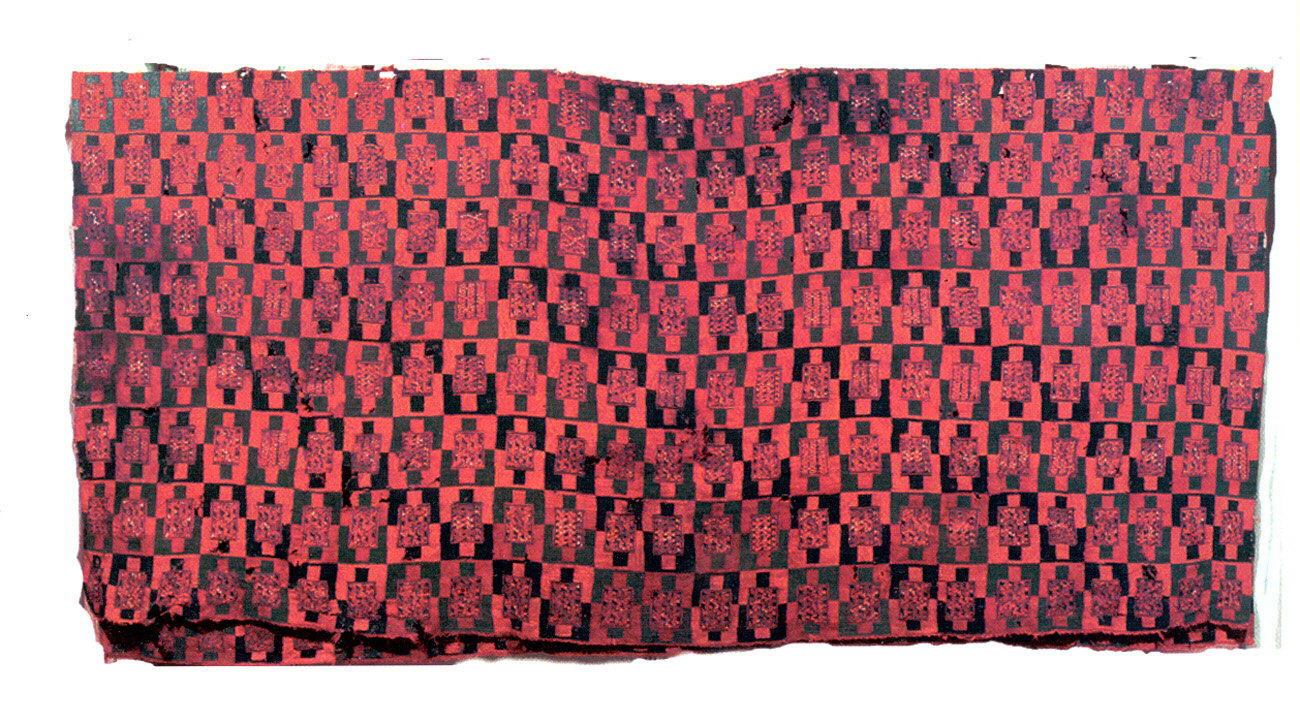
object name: poncho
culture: chuquibamba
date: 1201-1500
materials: animal fiber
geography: peru